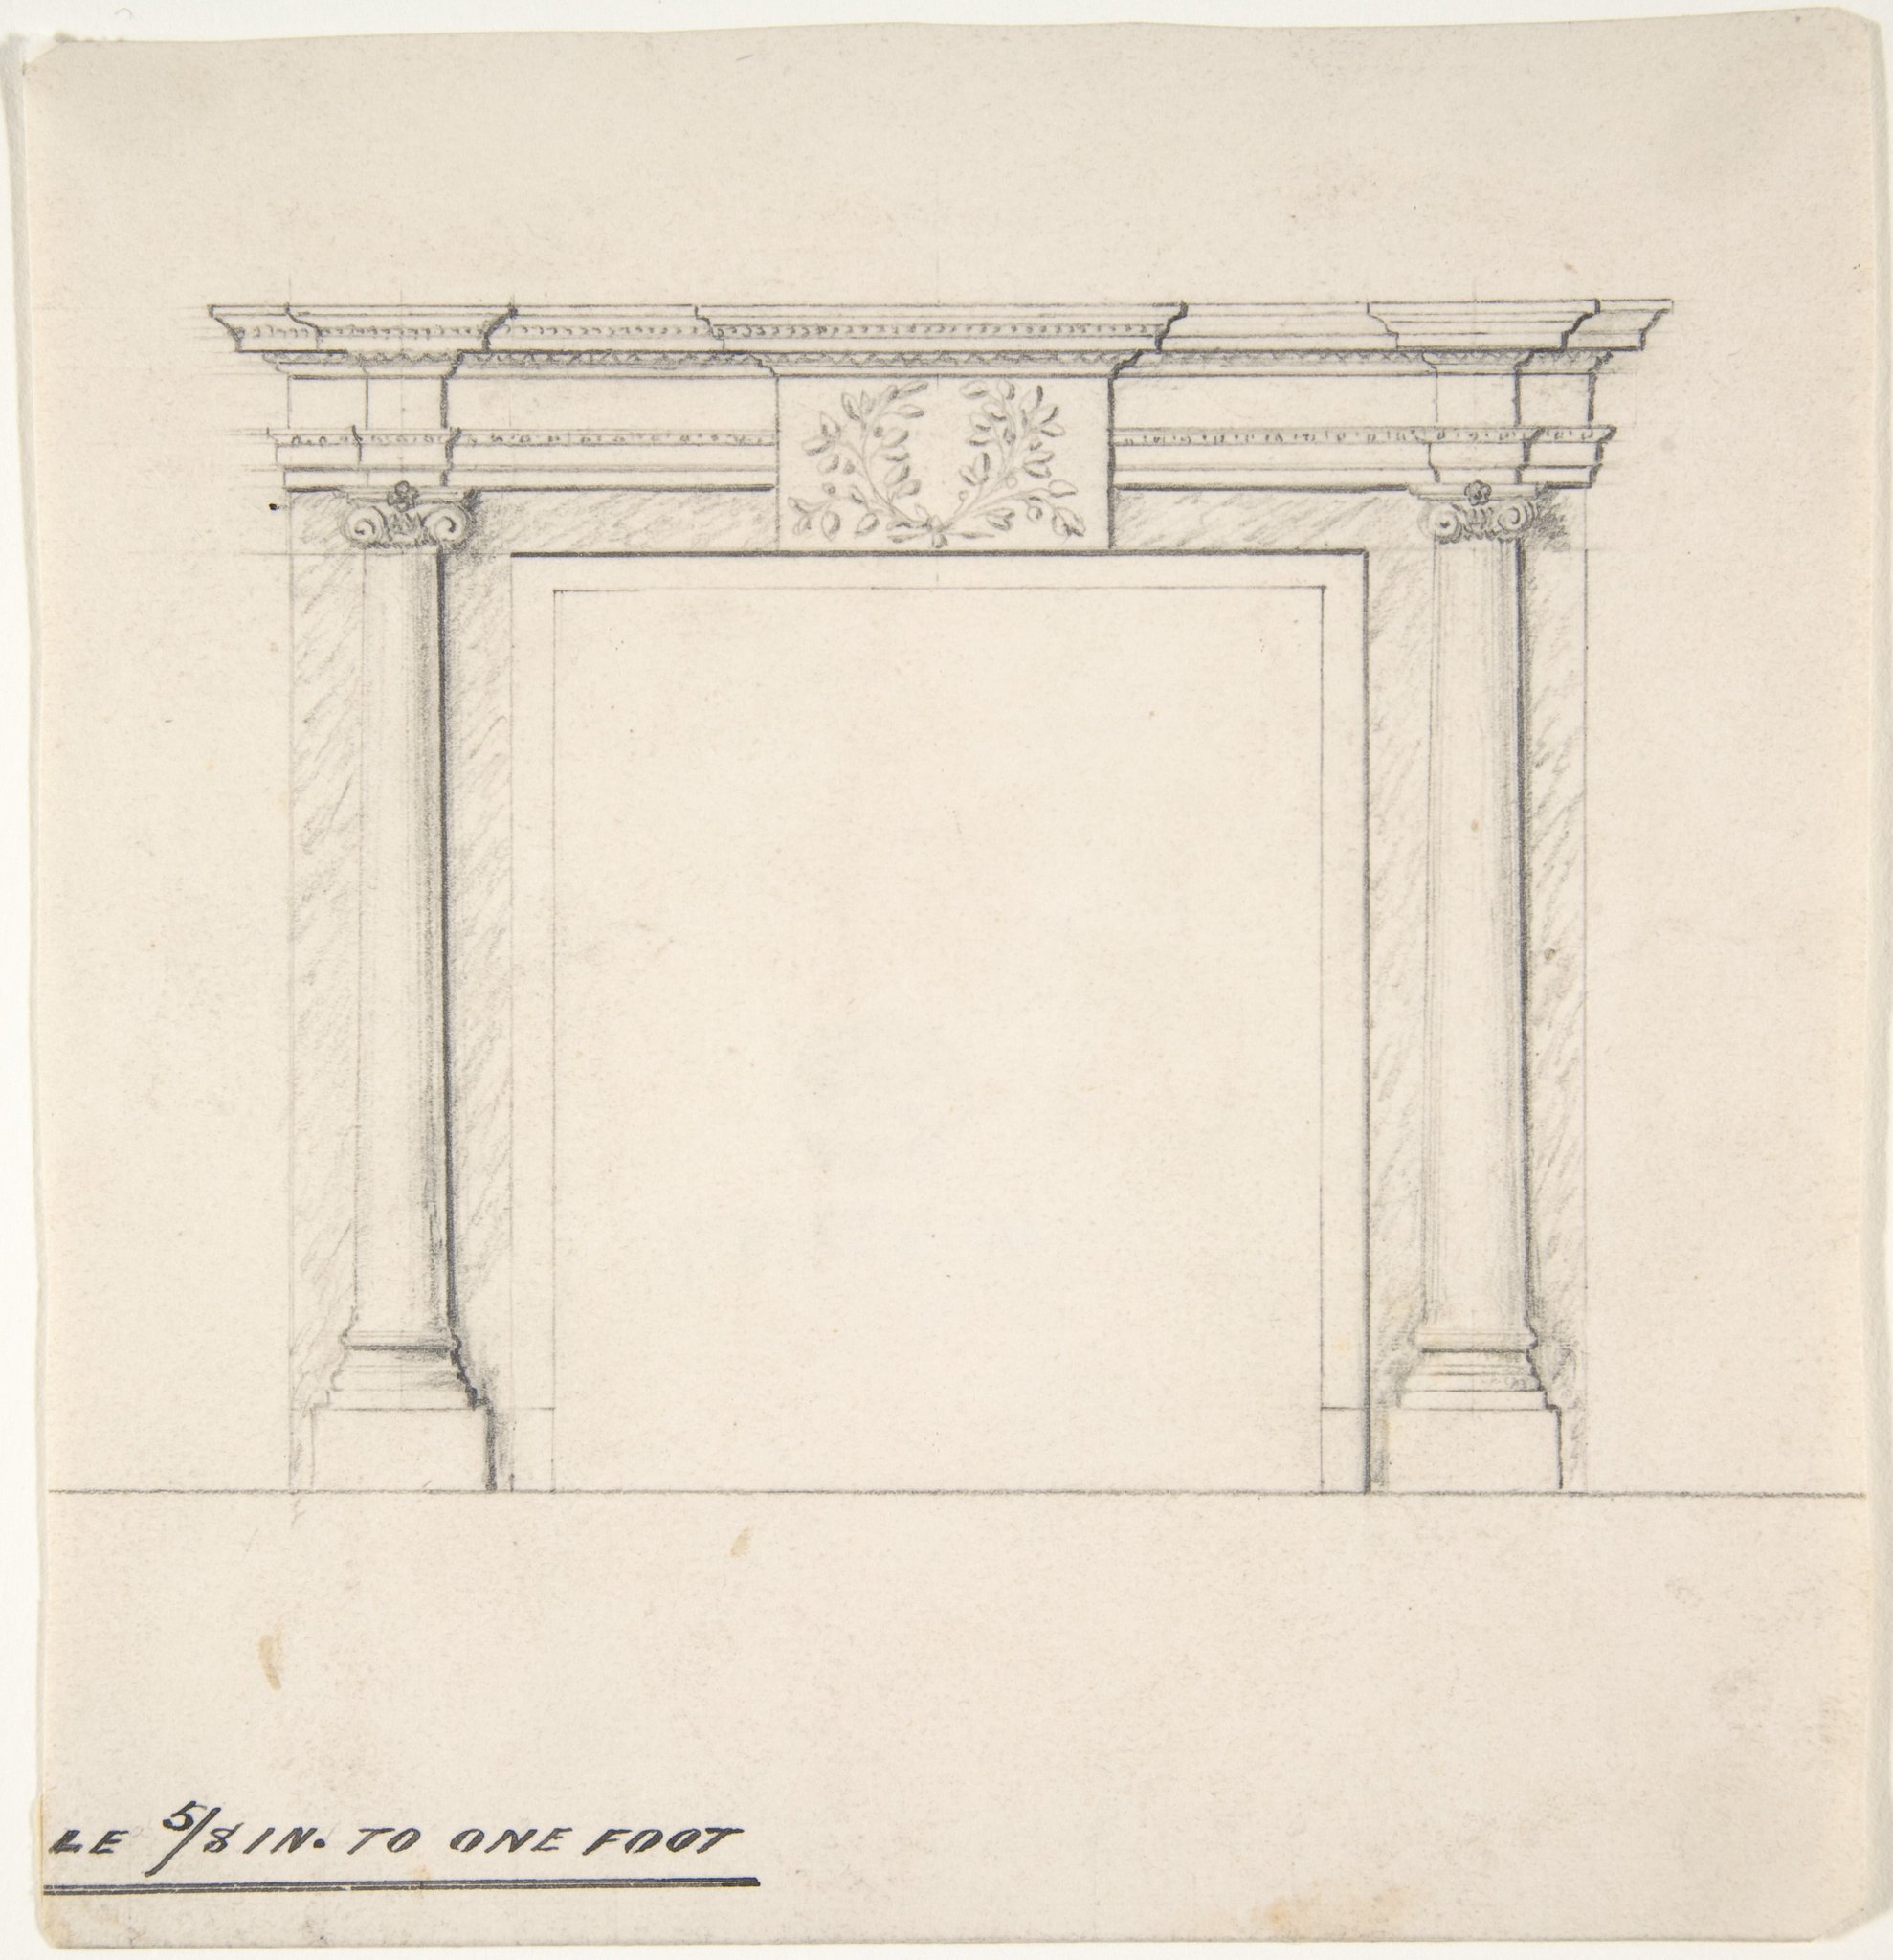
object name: drawing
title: Fireplace Design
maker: anonymous, british, 19th century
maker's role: artist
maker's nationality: british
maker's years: 1800-1900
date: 1801-1900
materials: graphite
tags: fireplaces